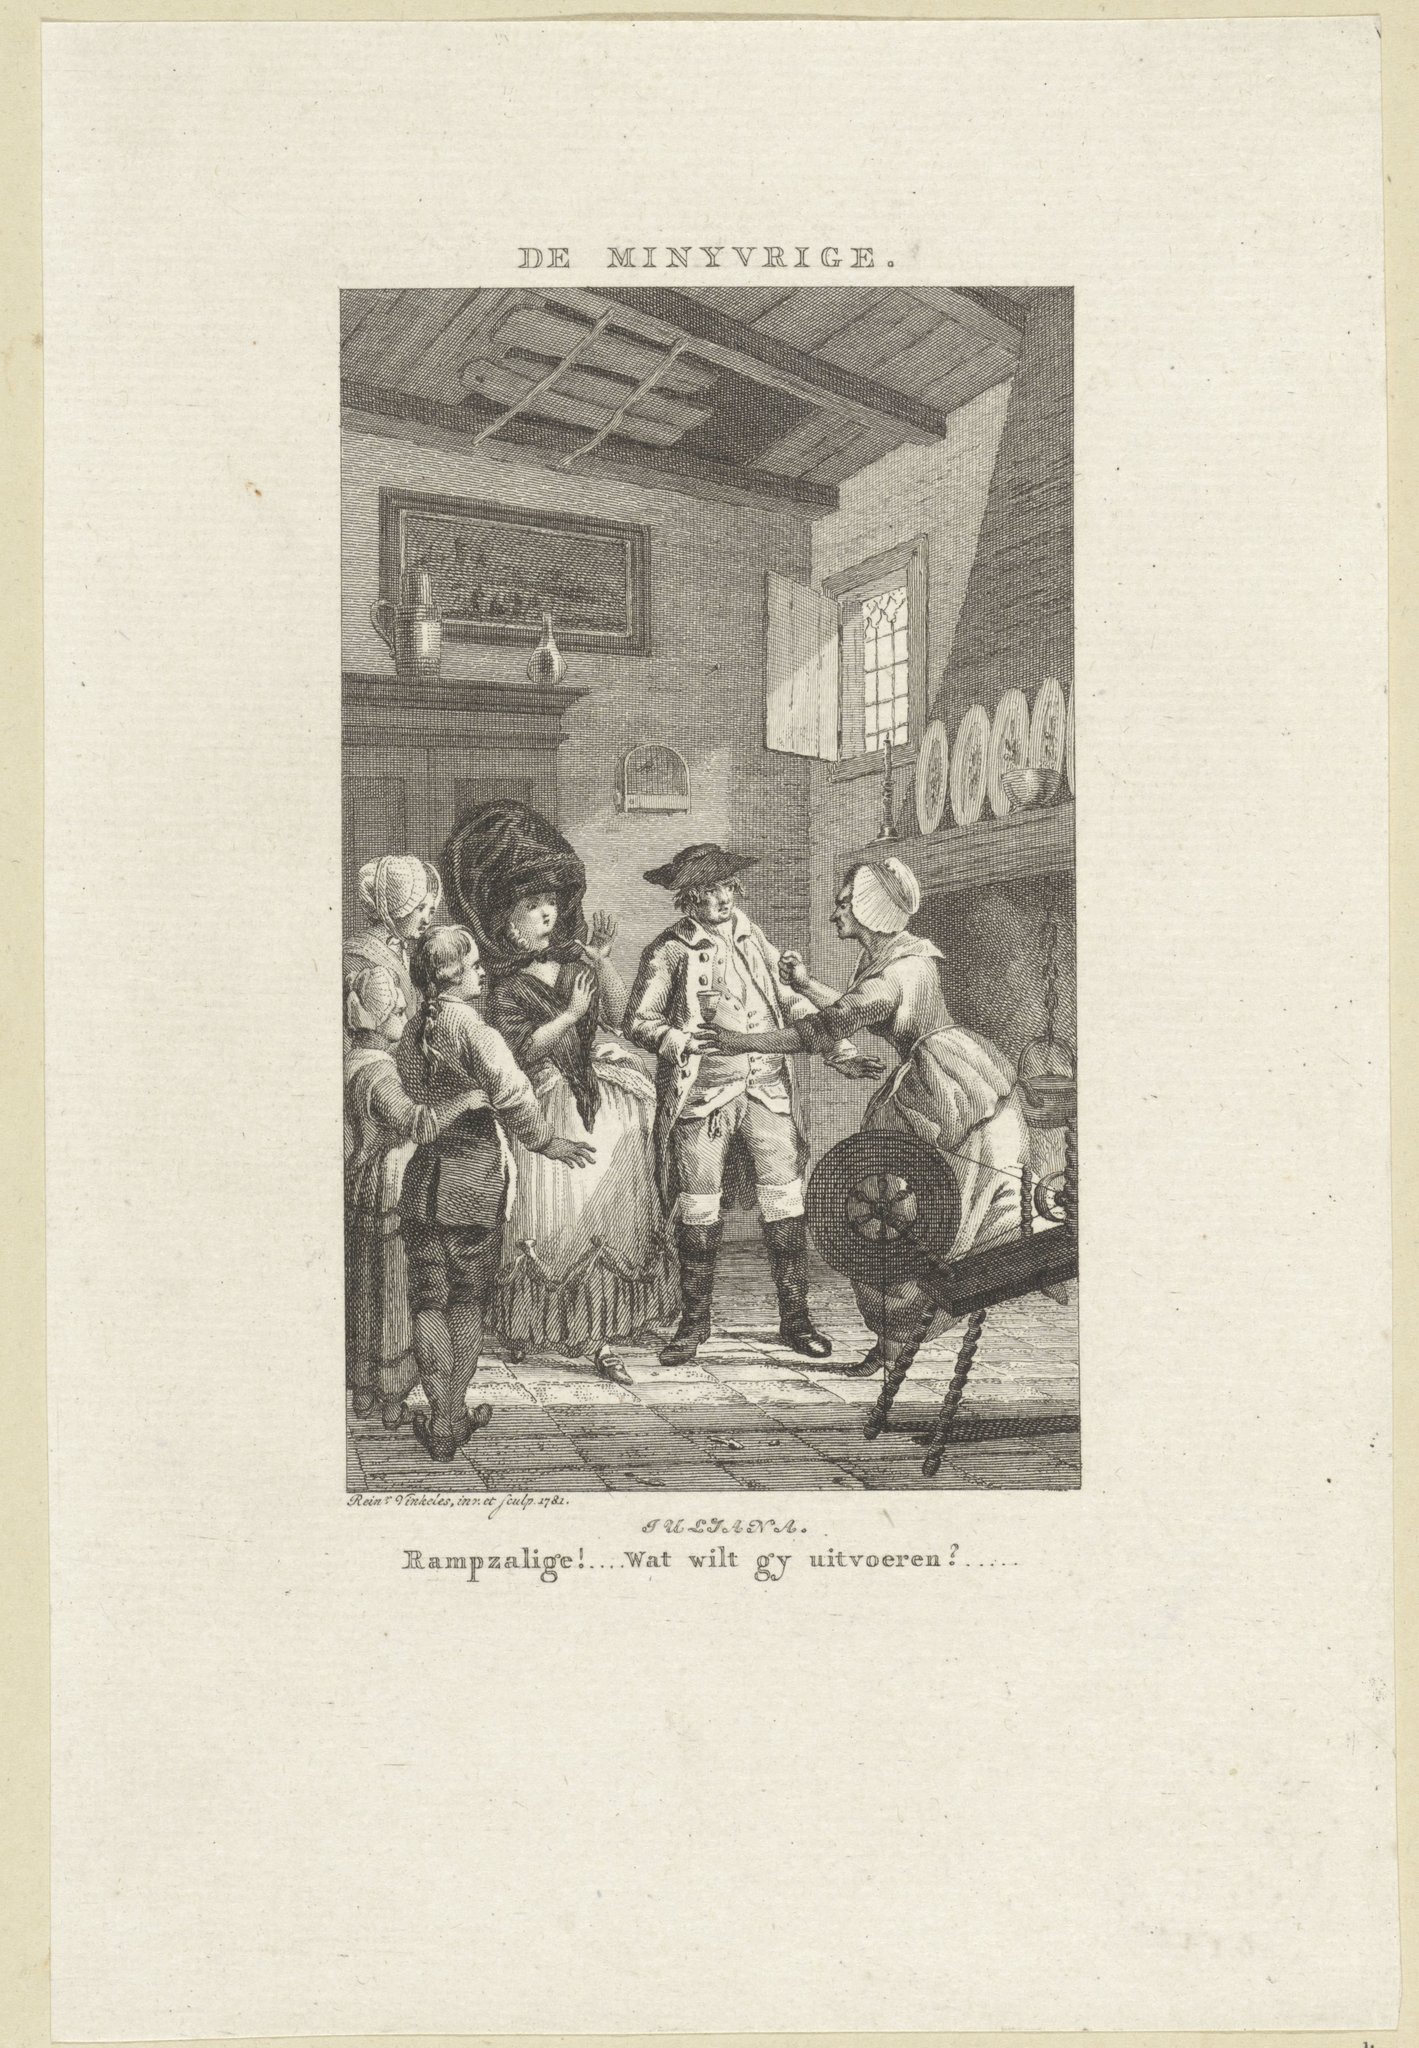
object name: print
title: Vrouw toont haar gebalde vuist aan een andere vrouw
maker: reinier vinkeles (i)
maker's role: draughtsman, print maker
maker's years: 1741-1816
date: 1790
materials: paper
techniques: engraving, etching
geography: amsterdam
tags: arm raised, with fist, open hearth, fire-place, picture, painting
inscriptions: collector's mark: Lugt 240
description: In een vertrek laat een woedende vrouw haar gebalde vuist zien aan een andere vrouw, die daar van lijkt te schrikken. Een man en een aantal kinderen kijken toe.